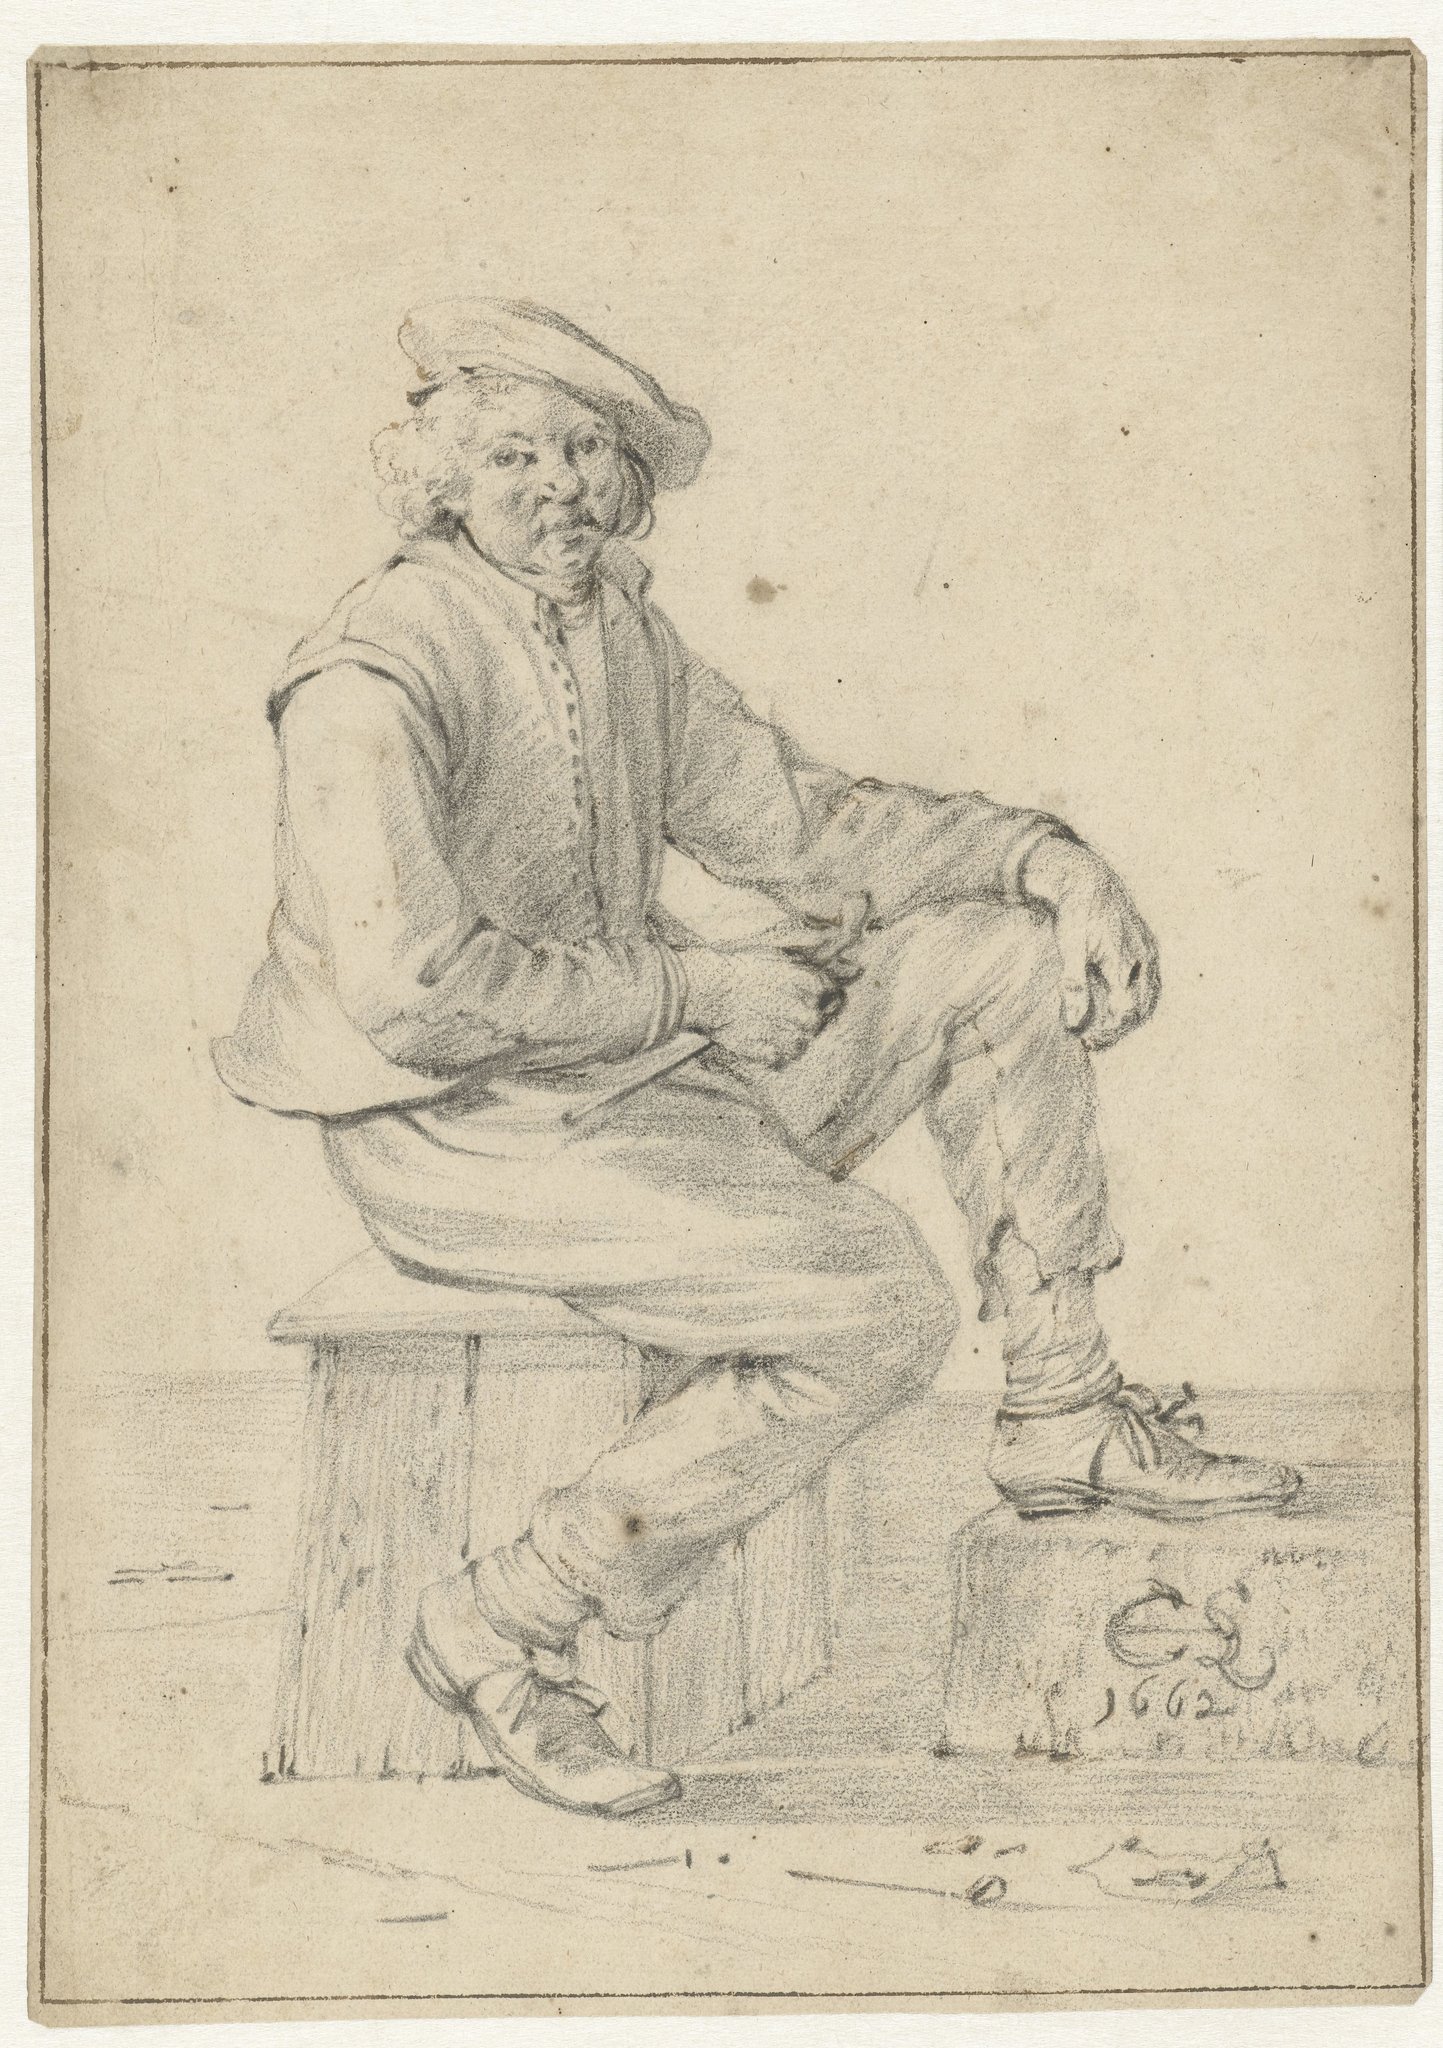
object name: drawing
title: Seated Man with a Pipe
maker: cornelis saftleven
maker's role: draughtsman, painter, print maker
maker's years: 1607-1681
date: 1662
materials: chalk, paper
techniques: drawing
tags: sitting figure, pipe ~ tobacco (+ taking (particular) foodstuffs: eating, drinking, smoking, chewing, etc.)